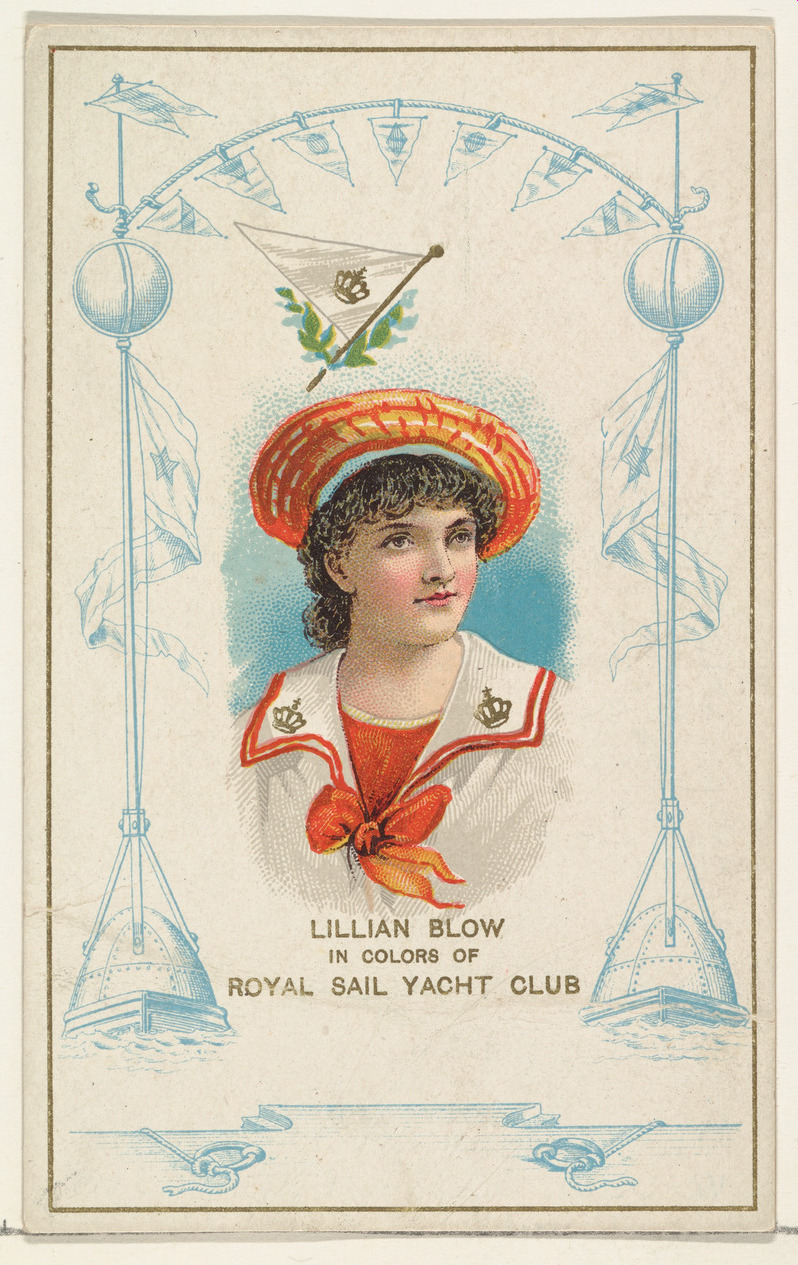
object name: print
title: Lillian Blow in Colors of Royal Sail Yacht Club, from the Yacht Colors of the World series (N140) issued by Duke Sons & Co. to promote Honest Long Cut Tobacco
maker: w. duke, sons & co.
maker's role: publisher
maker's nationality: american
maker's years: 1870-1920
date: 1890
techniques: color lithograph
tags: profiles,women